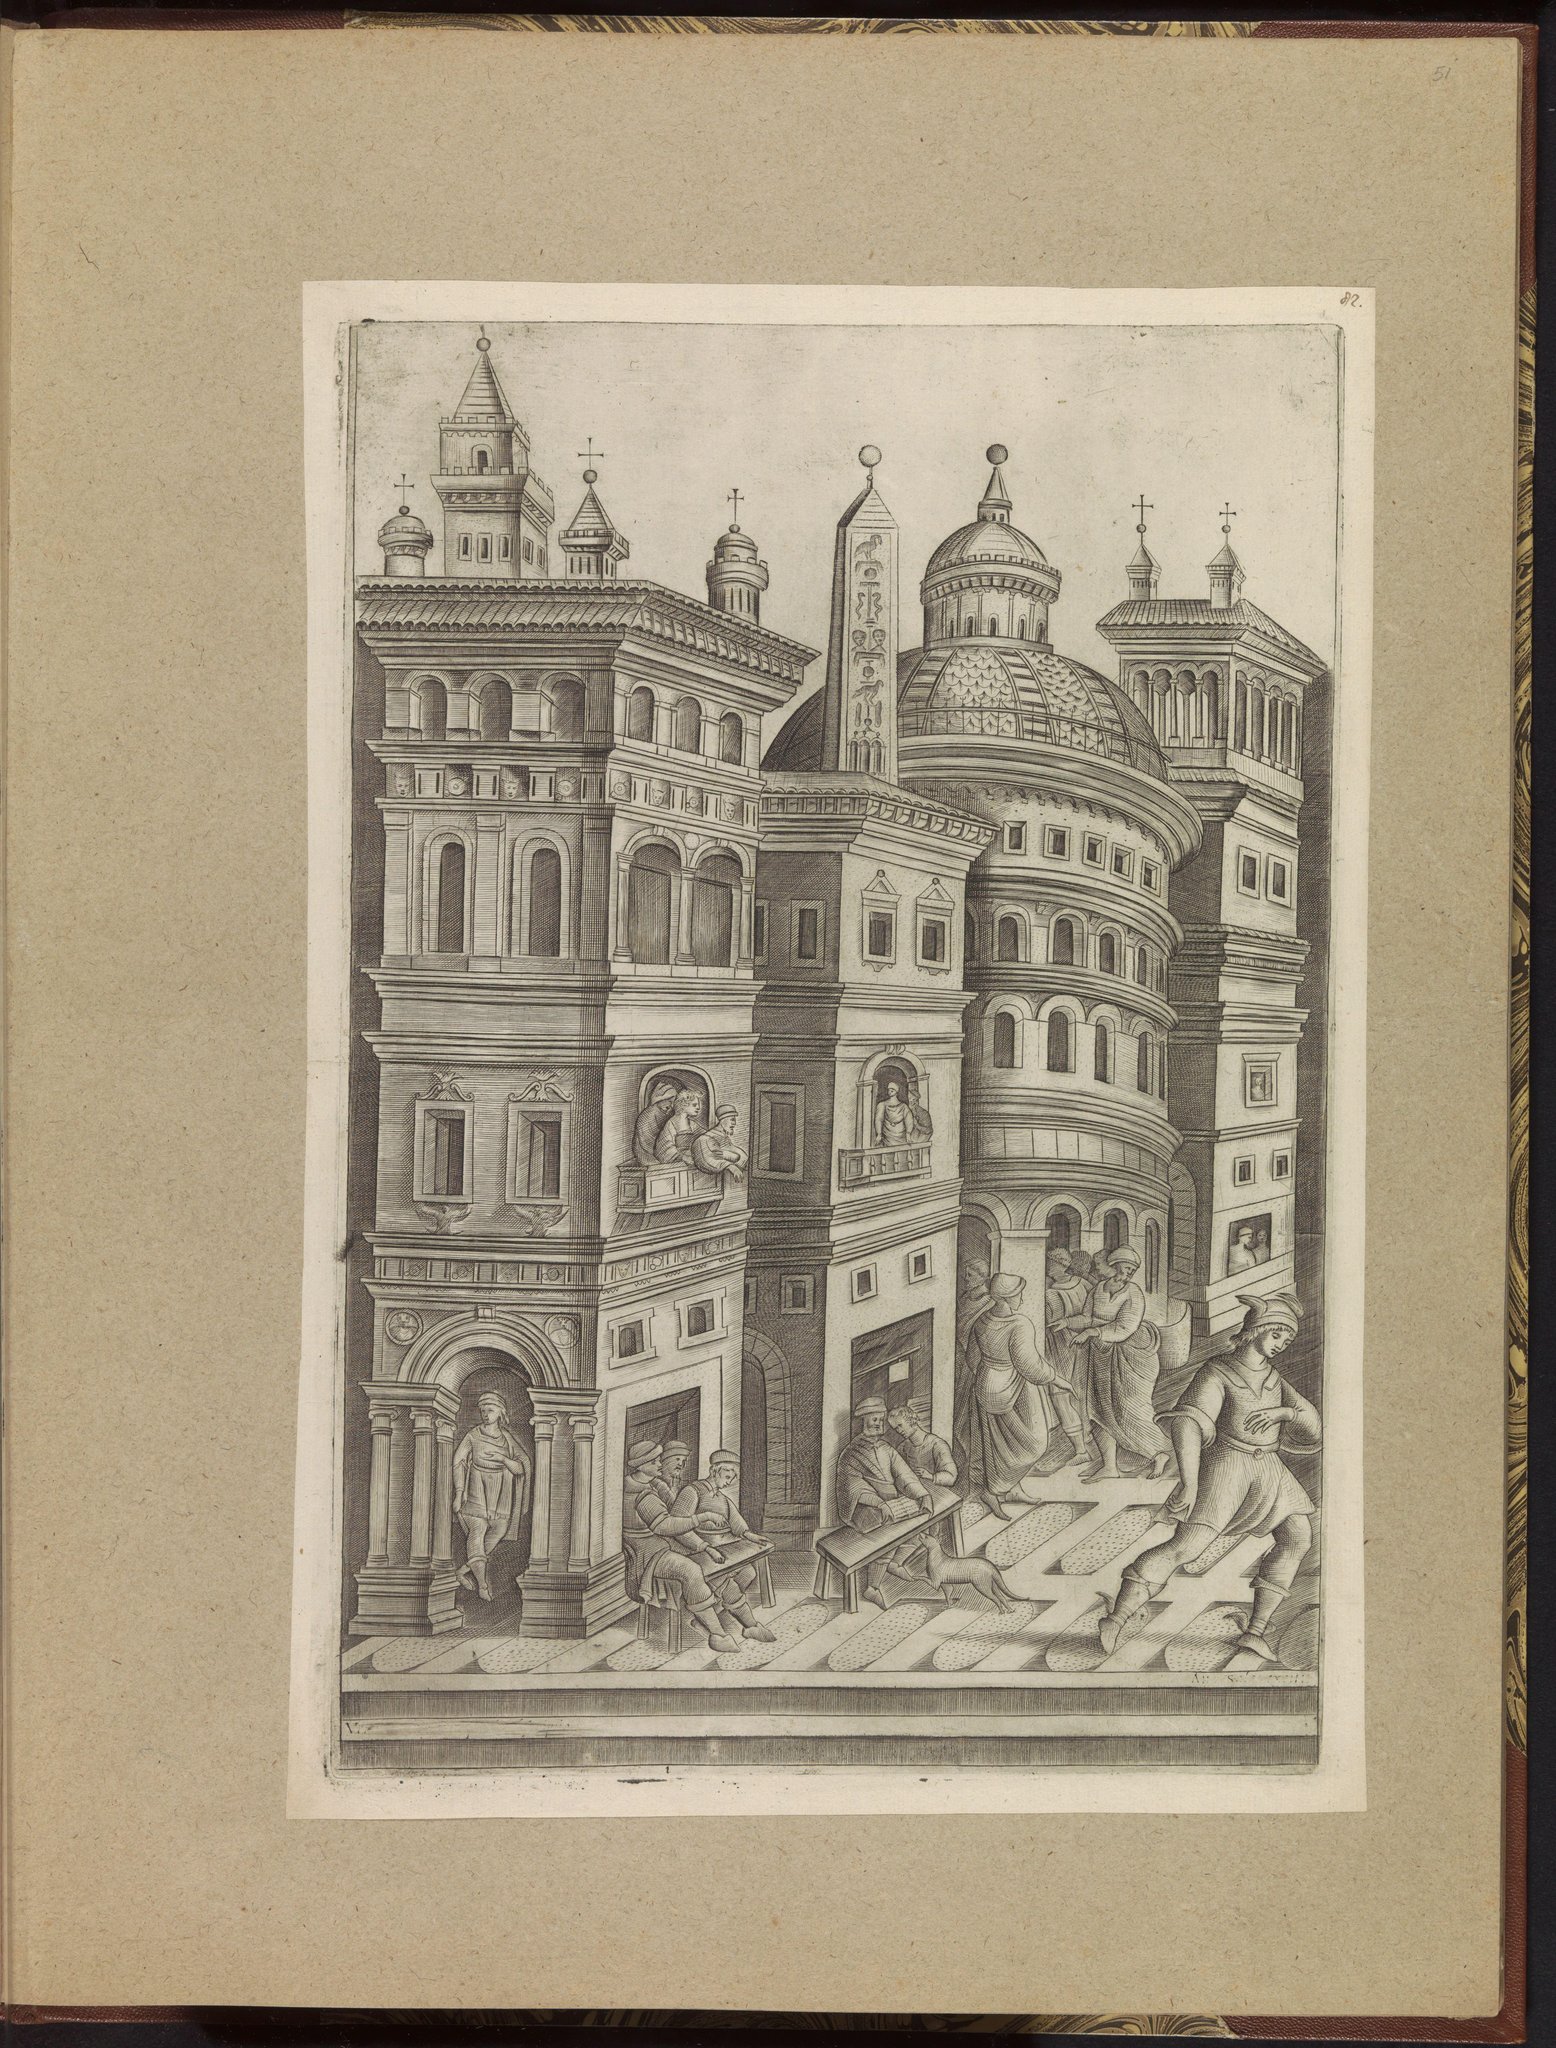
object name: album leaf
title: Vera Antiqui Capitolii Descriptio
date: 1595-1622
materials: paper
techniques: engraving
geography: rome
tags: city-view, and landscape with man-made constructions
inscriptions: number: ‘82’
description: Deze prent kan samen met twee andere prenten in het album tot een drieluik worden samengeplakt. Deze prent behoort tot het prentcorpus dat bekend staat als de ‘Speculum Romanae Magnificentiae’ (‘Spiegel van Romeinse pracht’). Dit corpus, bestaande uit prenten met voorstellingen van kunstwerken en gebouwen uit het antieke en het moderne Rome, vond zijn oorsprong bij uitgevers Antonio Salamanca en Antonio Lafreri. Deze twee buitenlandse uitgevers bundelden hun krachten te Rome in de periode 1553-1563. Hun prenten werden al snel razend populair bij toeristen en verzamelaars, die de prenten individueel of in grote groepen aanschaften. Grote groepen Speculum-prenten werden vaak op aanvraag samengebonden in albums. Er zijn verschillende Speculum-albums overgeleverd die allemaal verschillen van inhoud. Tussen 1573 en 1577 gaf Antonio Lafreri een speciale titelpagina uit (met de titel ‘Speculum Romanae Magnificentiae’) die mensen voor hun verzamelingen konden voegen. Het overlijden van Lafreri in 1577 betekende niet het einde van het corpus. Een groot deel van de koperplaten ging over op Claudio en Stefano Duchetti. De rest raakte verspreid over verschillende andere uitgevers. De populariteit van de Speculum-prenten wist nog geruime periode uitgevers te inspireren tot het laten maken van kopieën en het toevoegen van nieuwe prenten aan het corpus.